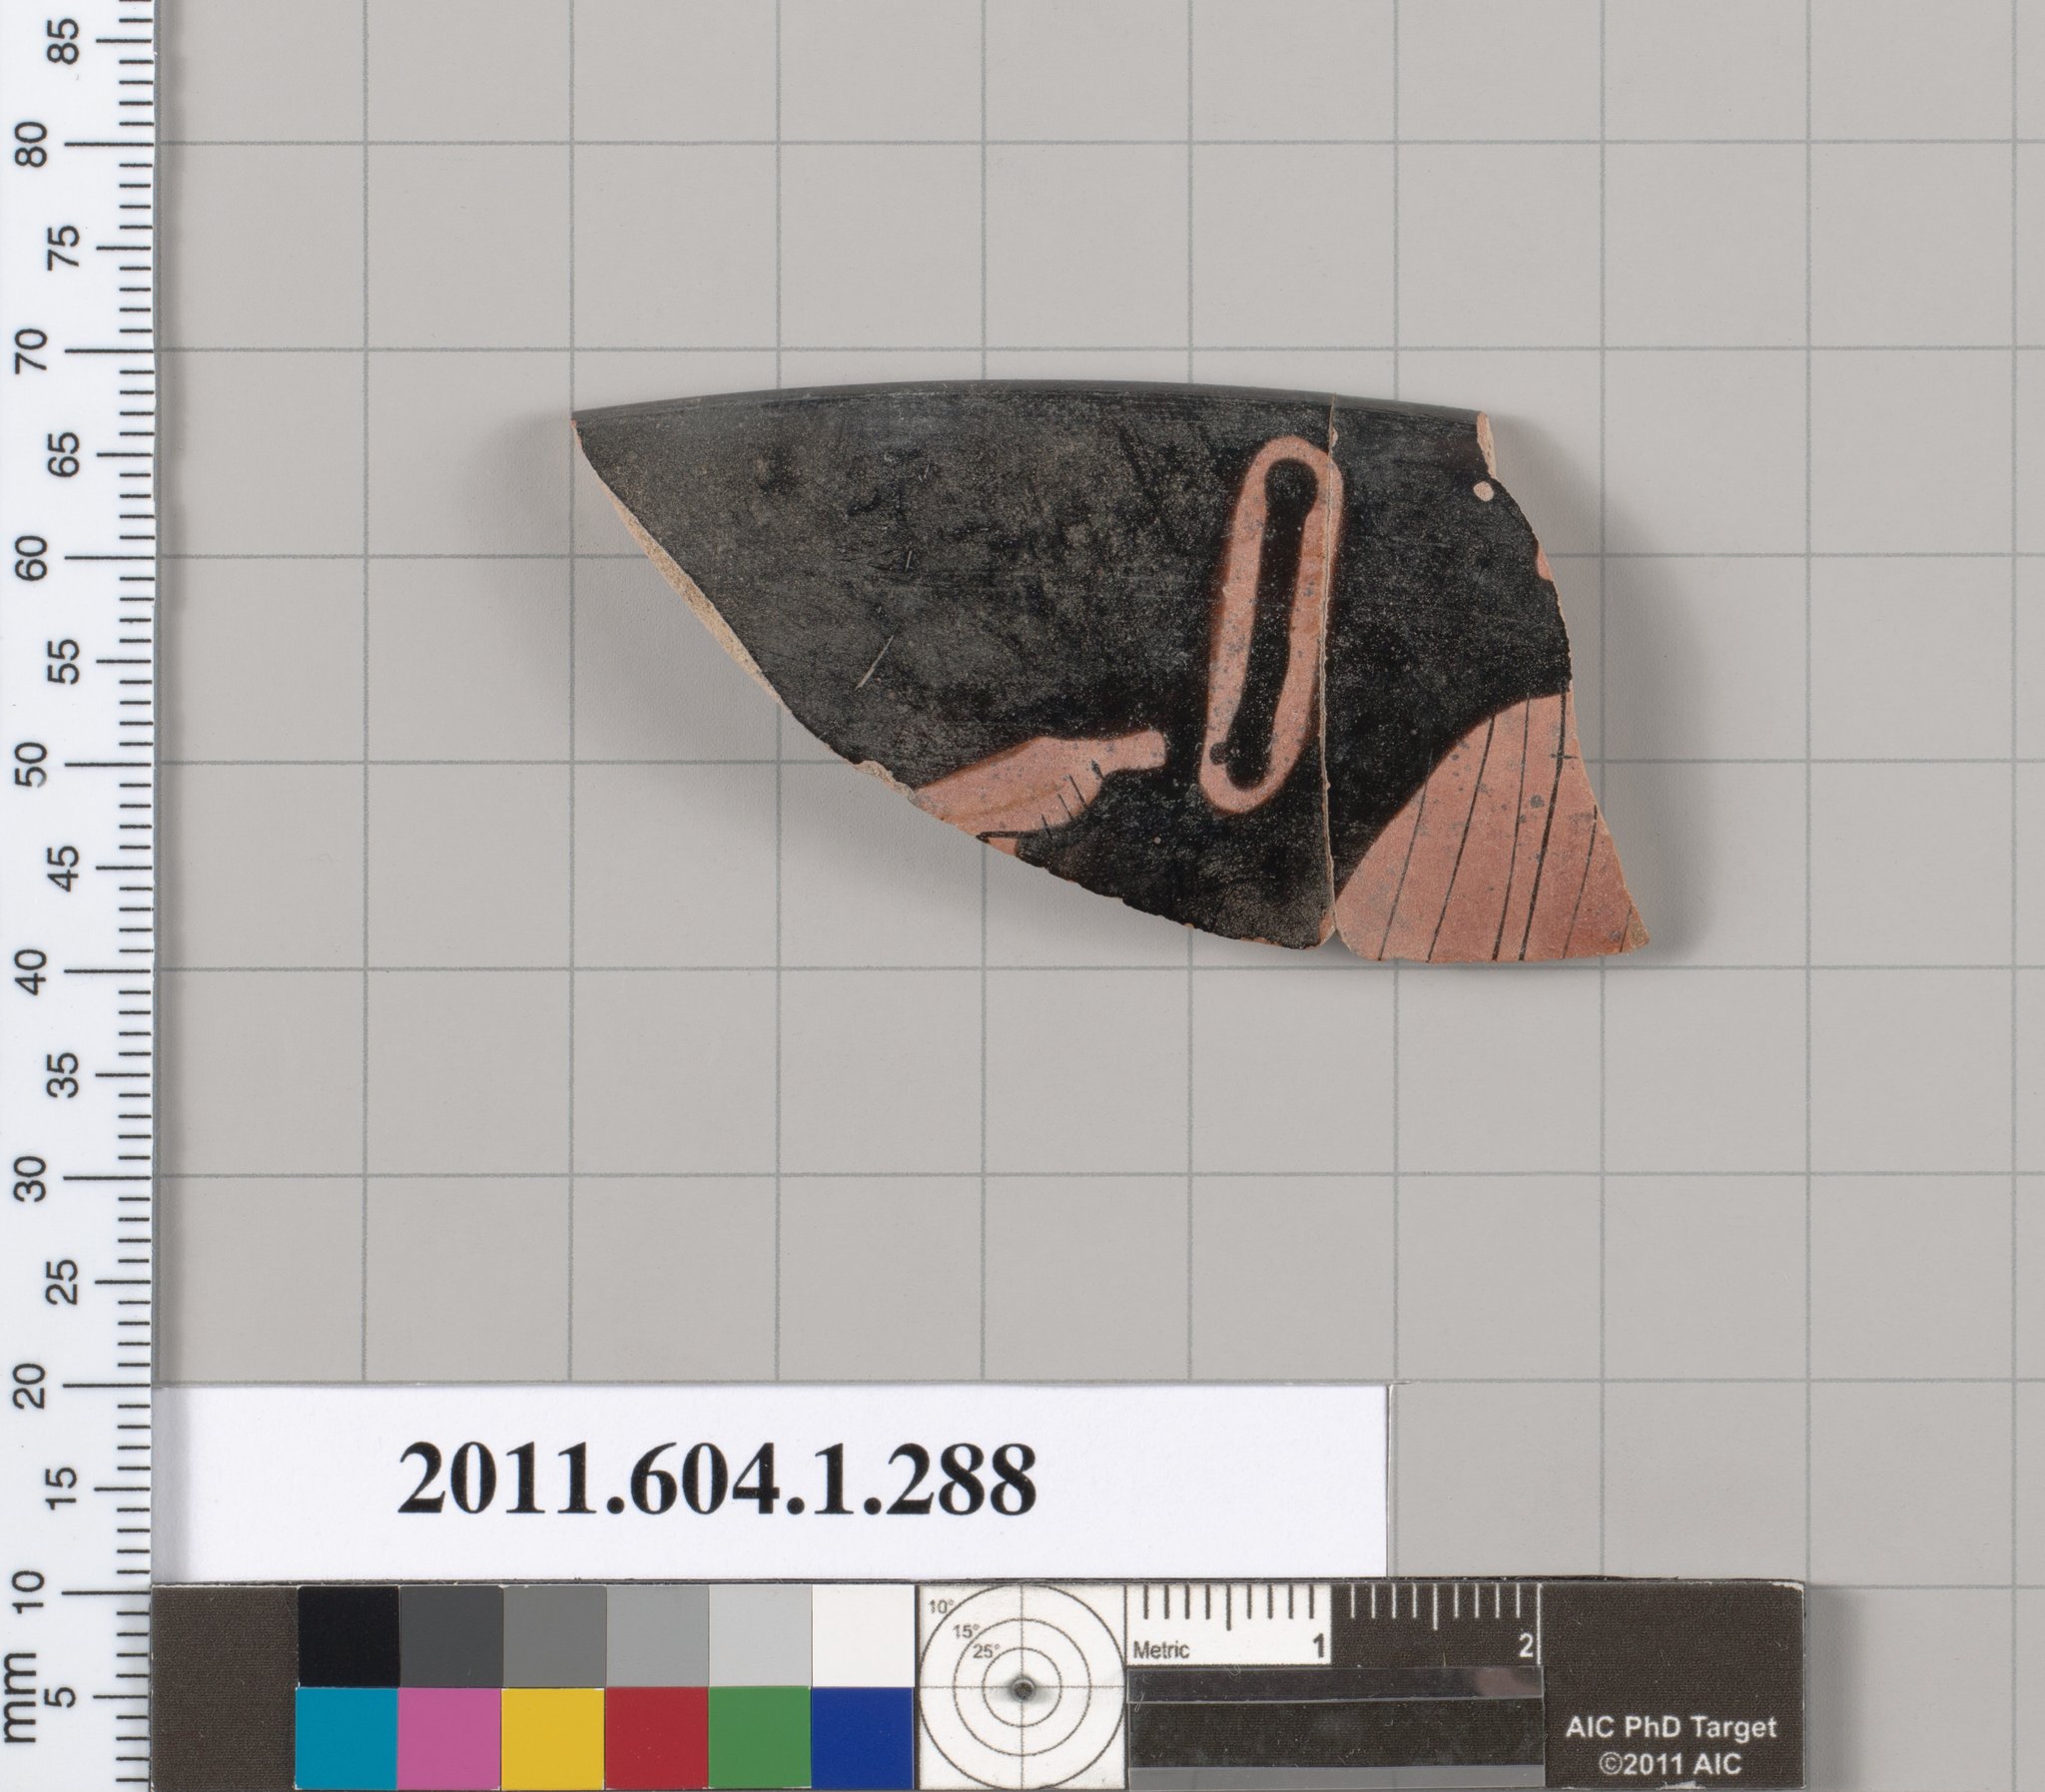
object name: kylix fragment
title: Terracotta rim fragment of a kylix (drinking cup)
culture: greek, attic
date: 475-451 BCE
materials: terracotta